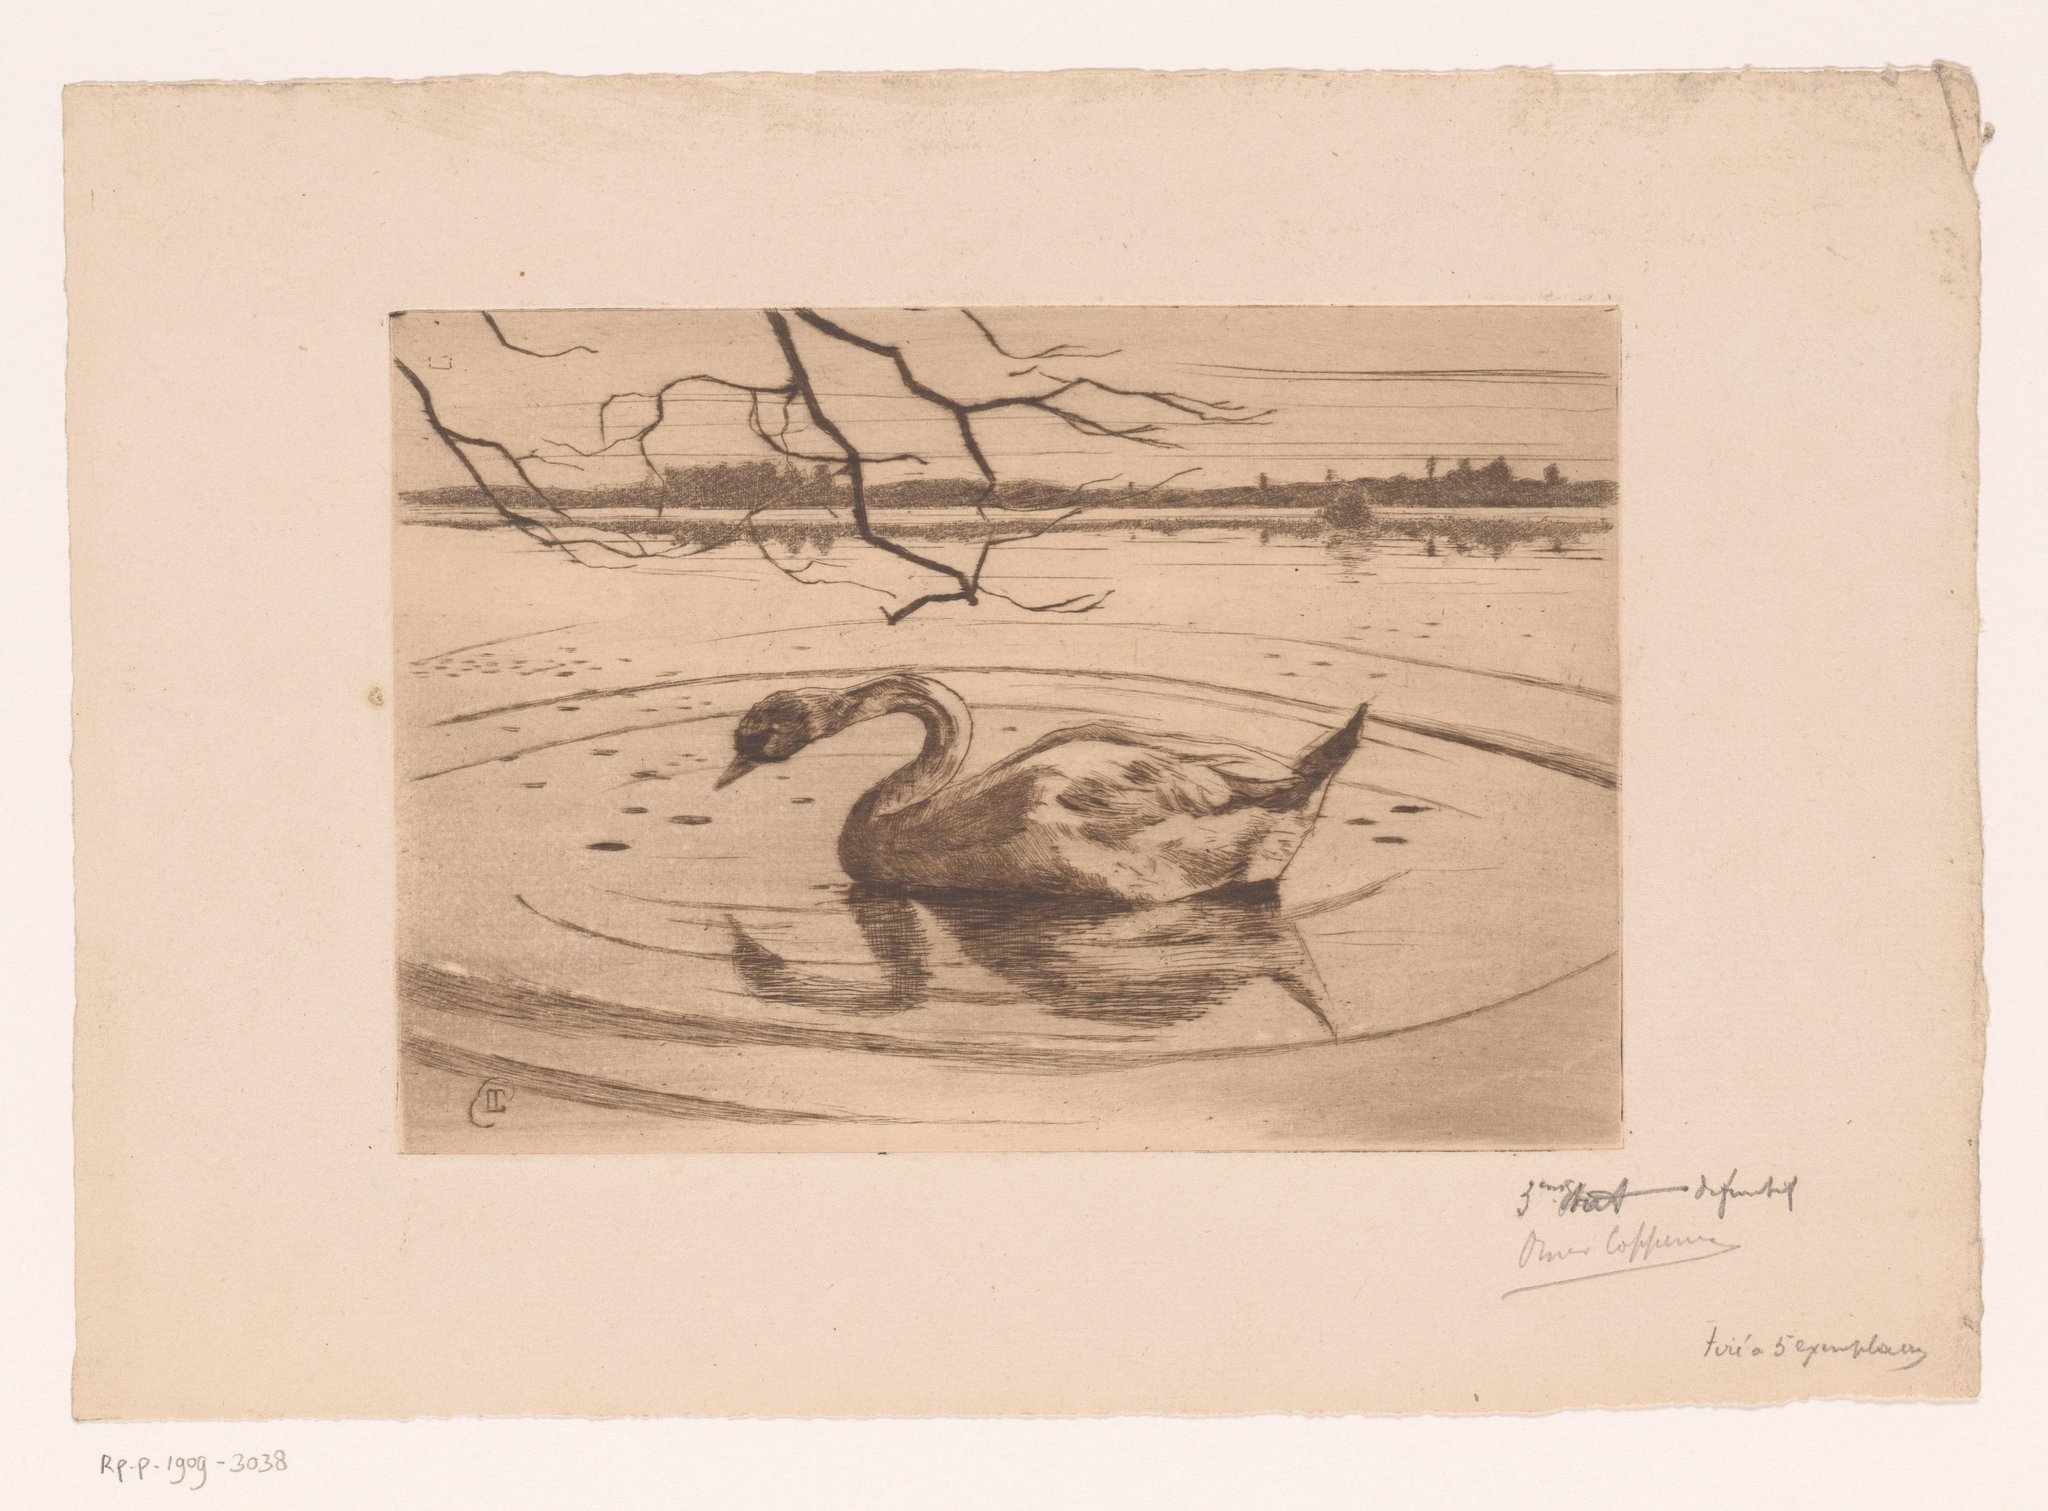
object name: print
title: Zwaan in een waterplas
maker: omer coppens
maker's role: print maker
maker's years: 1864-1926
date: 1874-1909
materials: paper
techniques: drypoint, etching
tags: landscapes, water-birds: swan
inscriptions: inscription: ‘3em Etat definitif; ... a 5 exemplaire’, inscription: ‘6 un cygne sur leau’, collector's mark: Lugt 2228